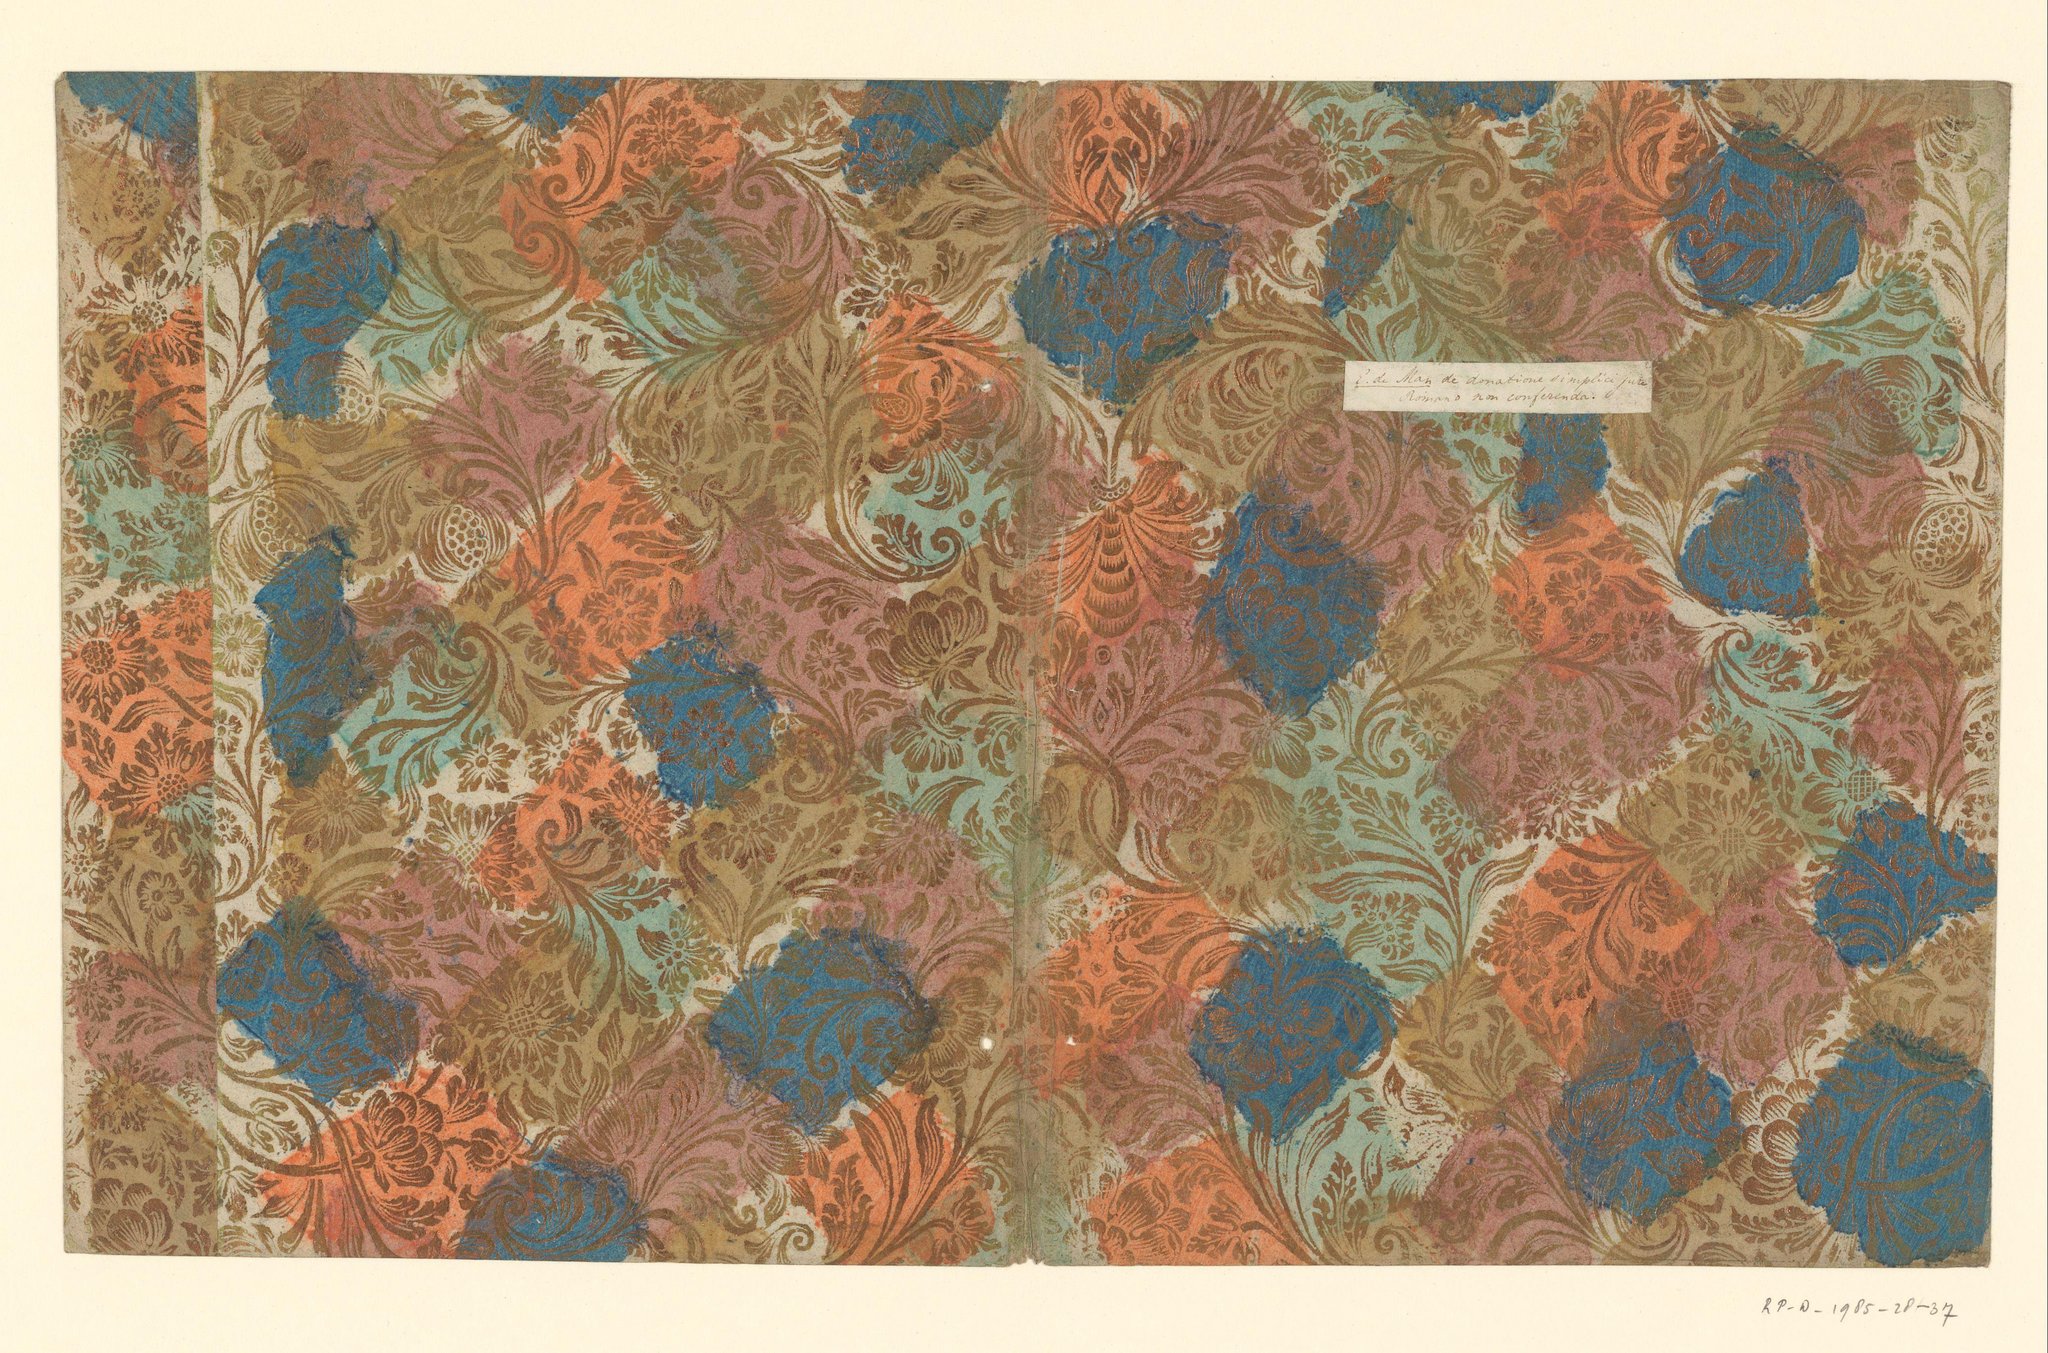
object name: wrapper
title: Blad met bloemen en vruchten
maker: Anonymous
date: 1700-1850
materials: gold leaf, paper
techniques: relief print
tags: ornament derived from plant forms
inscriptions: collector's mark: Lugt 2760, collector's mark: Lugt 2228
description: Blad met bloemen en vruchten, met kleuring in ruitenpatroon. Met etiket met opschrift: 'E. de Man ... conferenda'. Gebruikt als omslag.